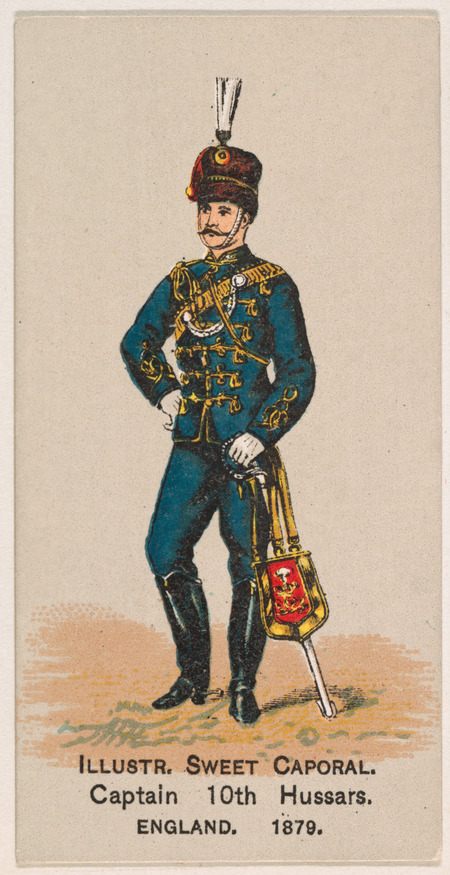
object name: print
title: Captain, 10th Hussars, England, 1879, from the Military Series (N224) issued by Kinney Tobacco Company to promote Sweet Caporal Cigarettes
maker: kinney brothers tobacco company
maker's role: publisher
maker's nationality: american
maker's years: 1869-2011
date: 1888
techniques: color lithograph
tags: military,swords,men